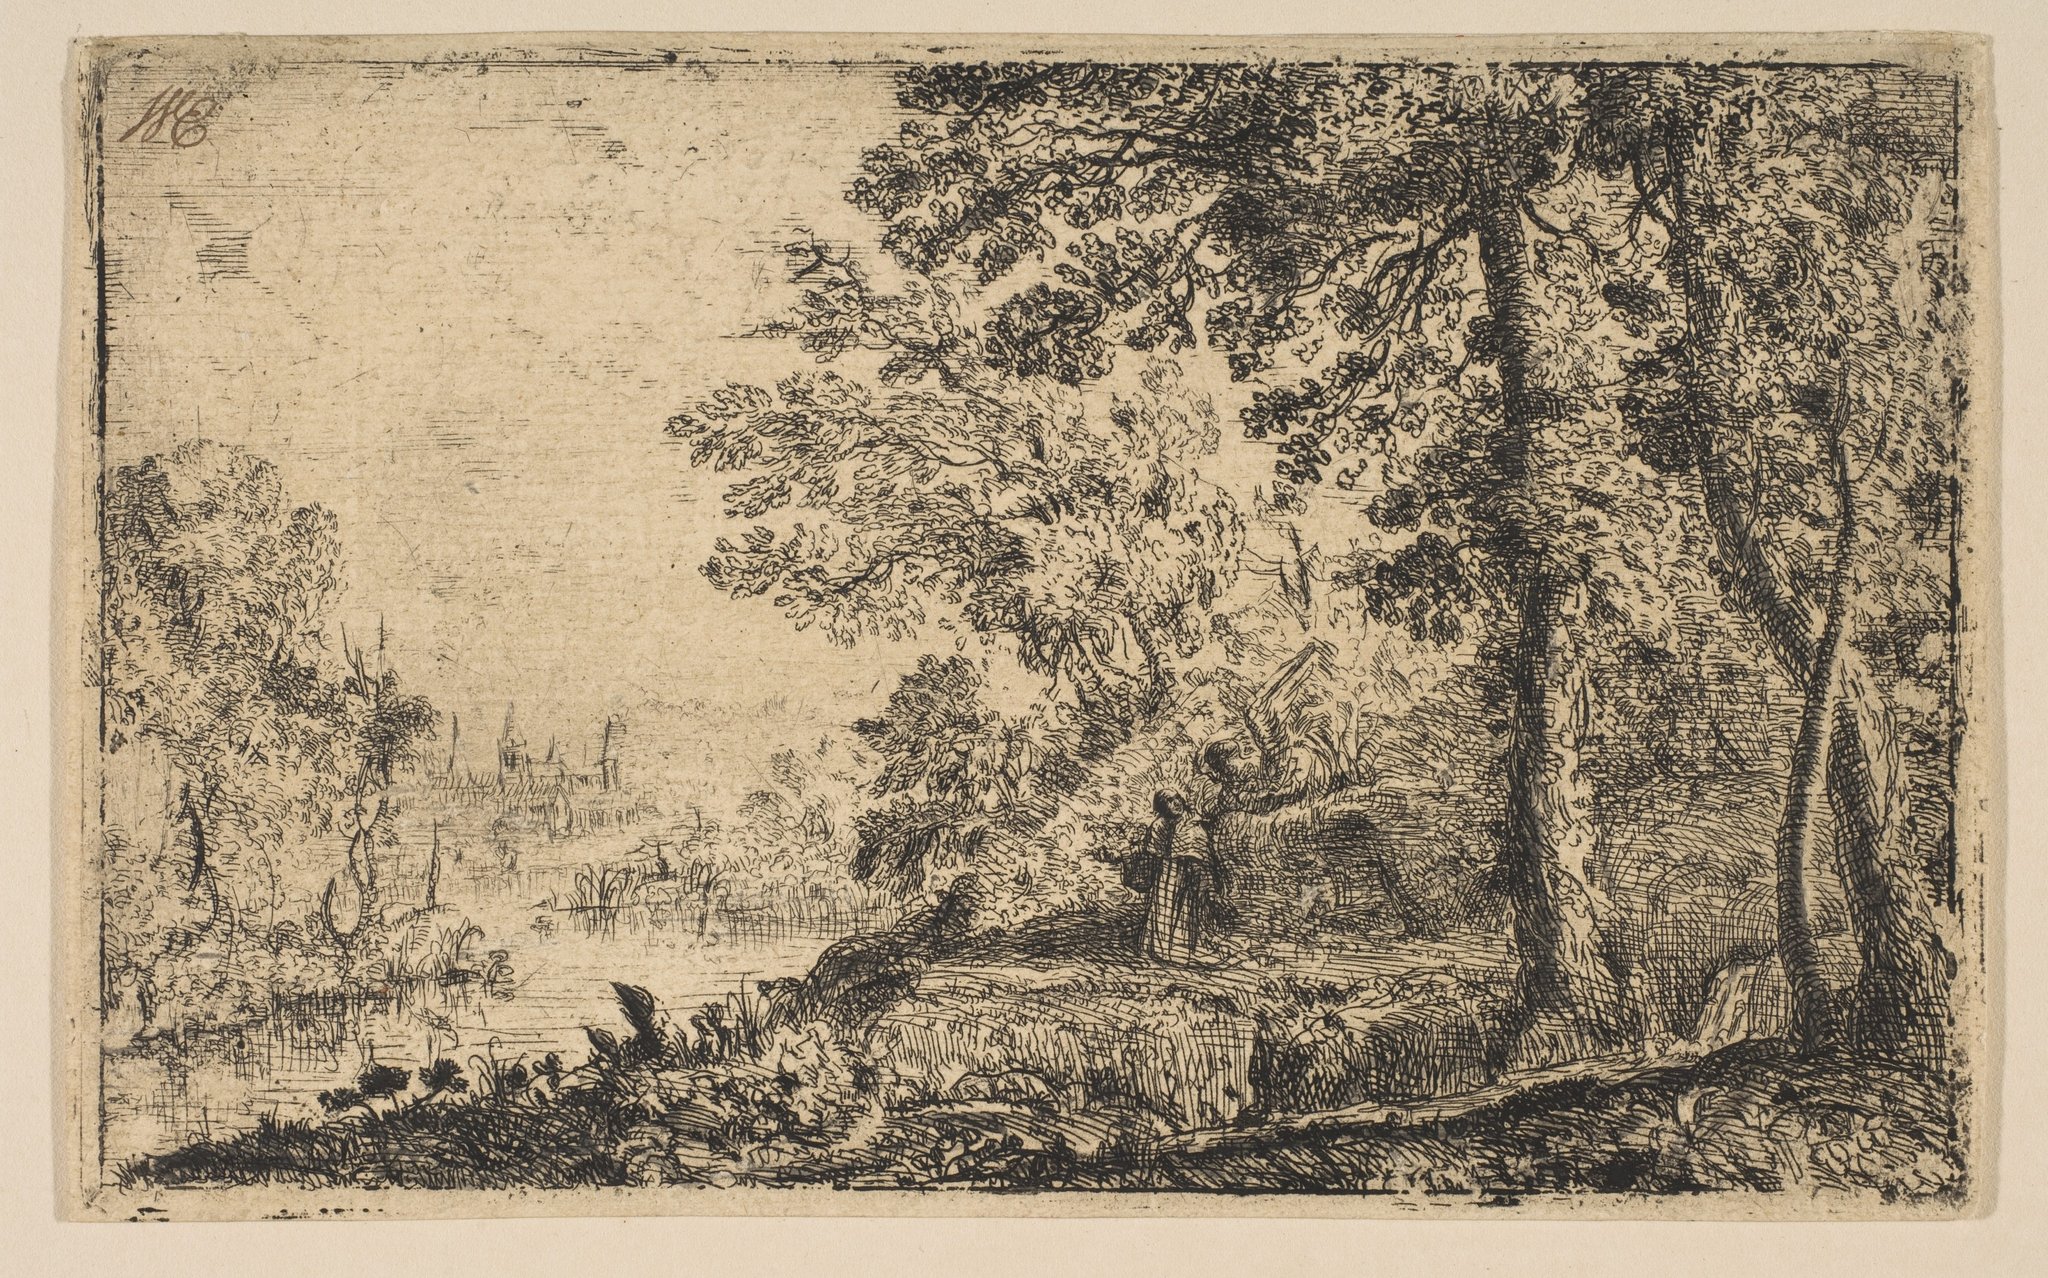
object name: print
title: The Vision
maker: claude lorrain (claude gellée)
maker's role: artist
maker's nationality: french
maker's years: 1604-1682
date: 1630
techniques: etching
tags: landscapes